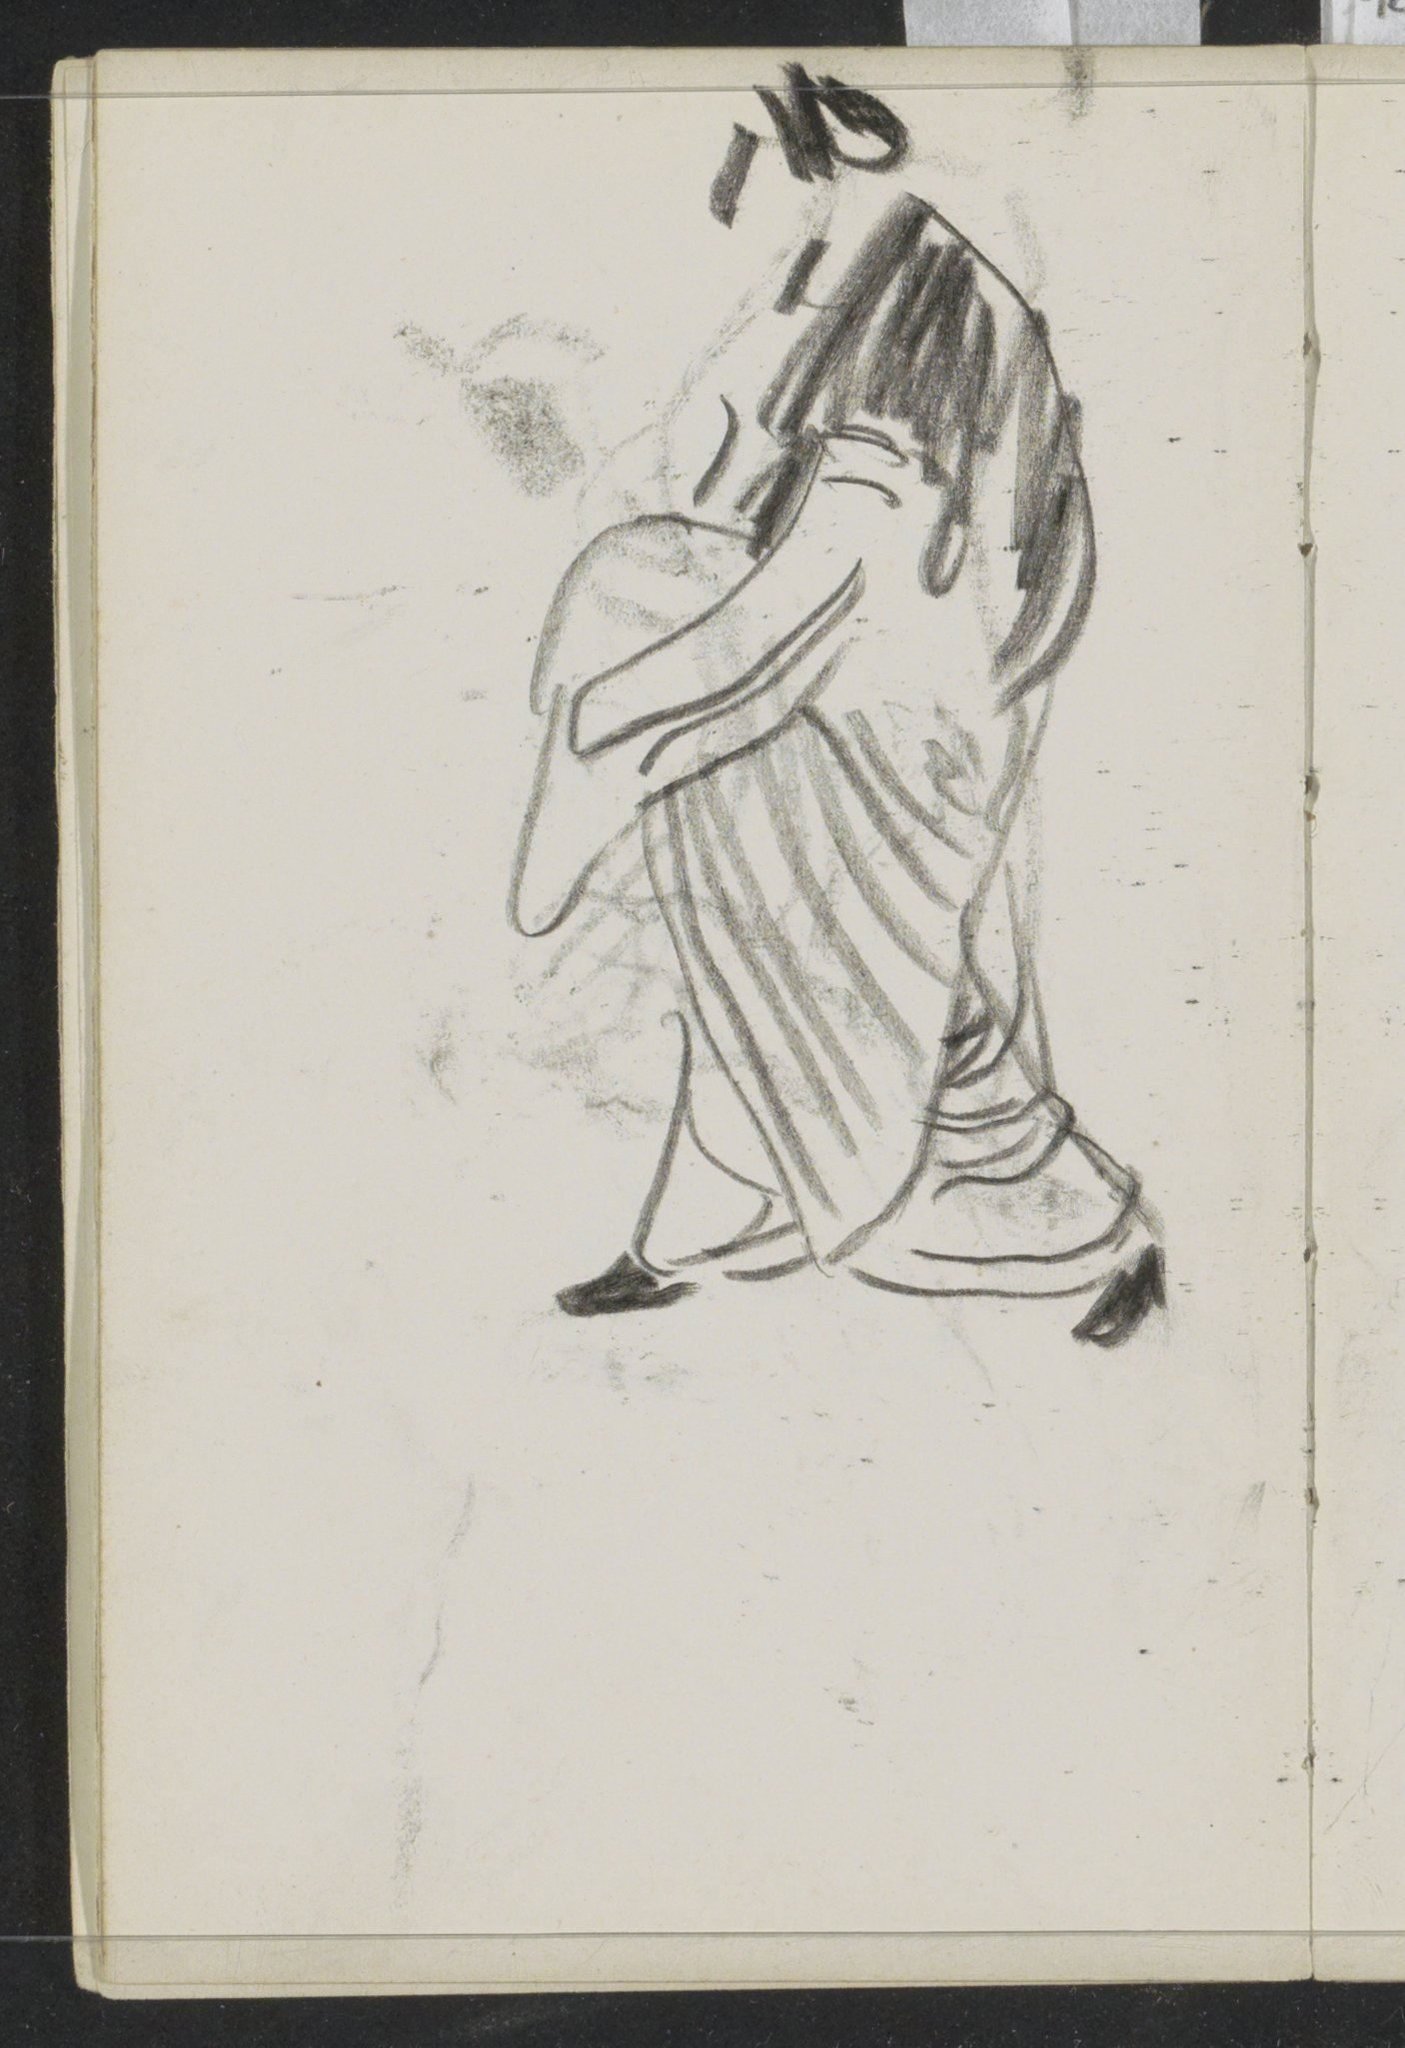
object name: sketchbook leaf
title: Figuur in oosterse kleding, vermoedelijk een kimono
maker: carel adolph lion cachet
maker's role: draughtsman, print maker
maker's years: 1864-1945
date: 1874-1945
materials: chalk, paper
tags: folk costume, regional costume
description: Blad 13 verso uit een schetsboek met 41 bladen.